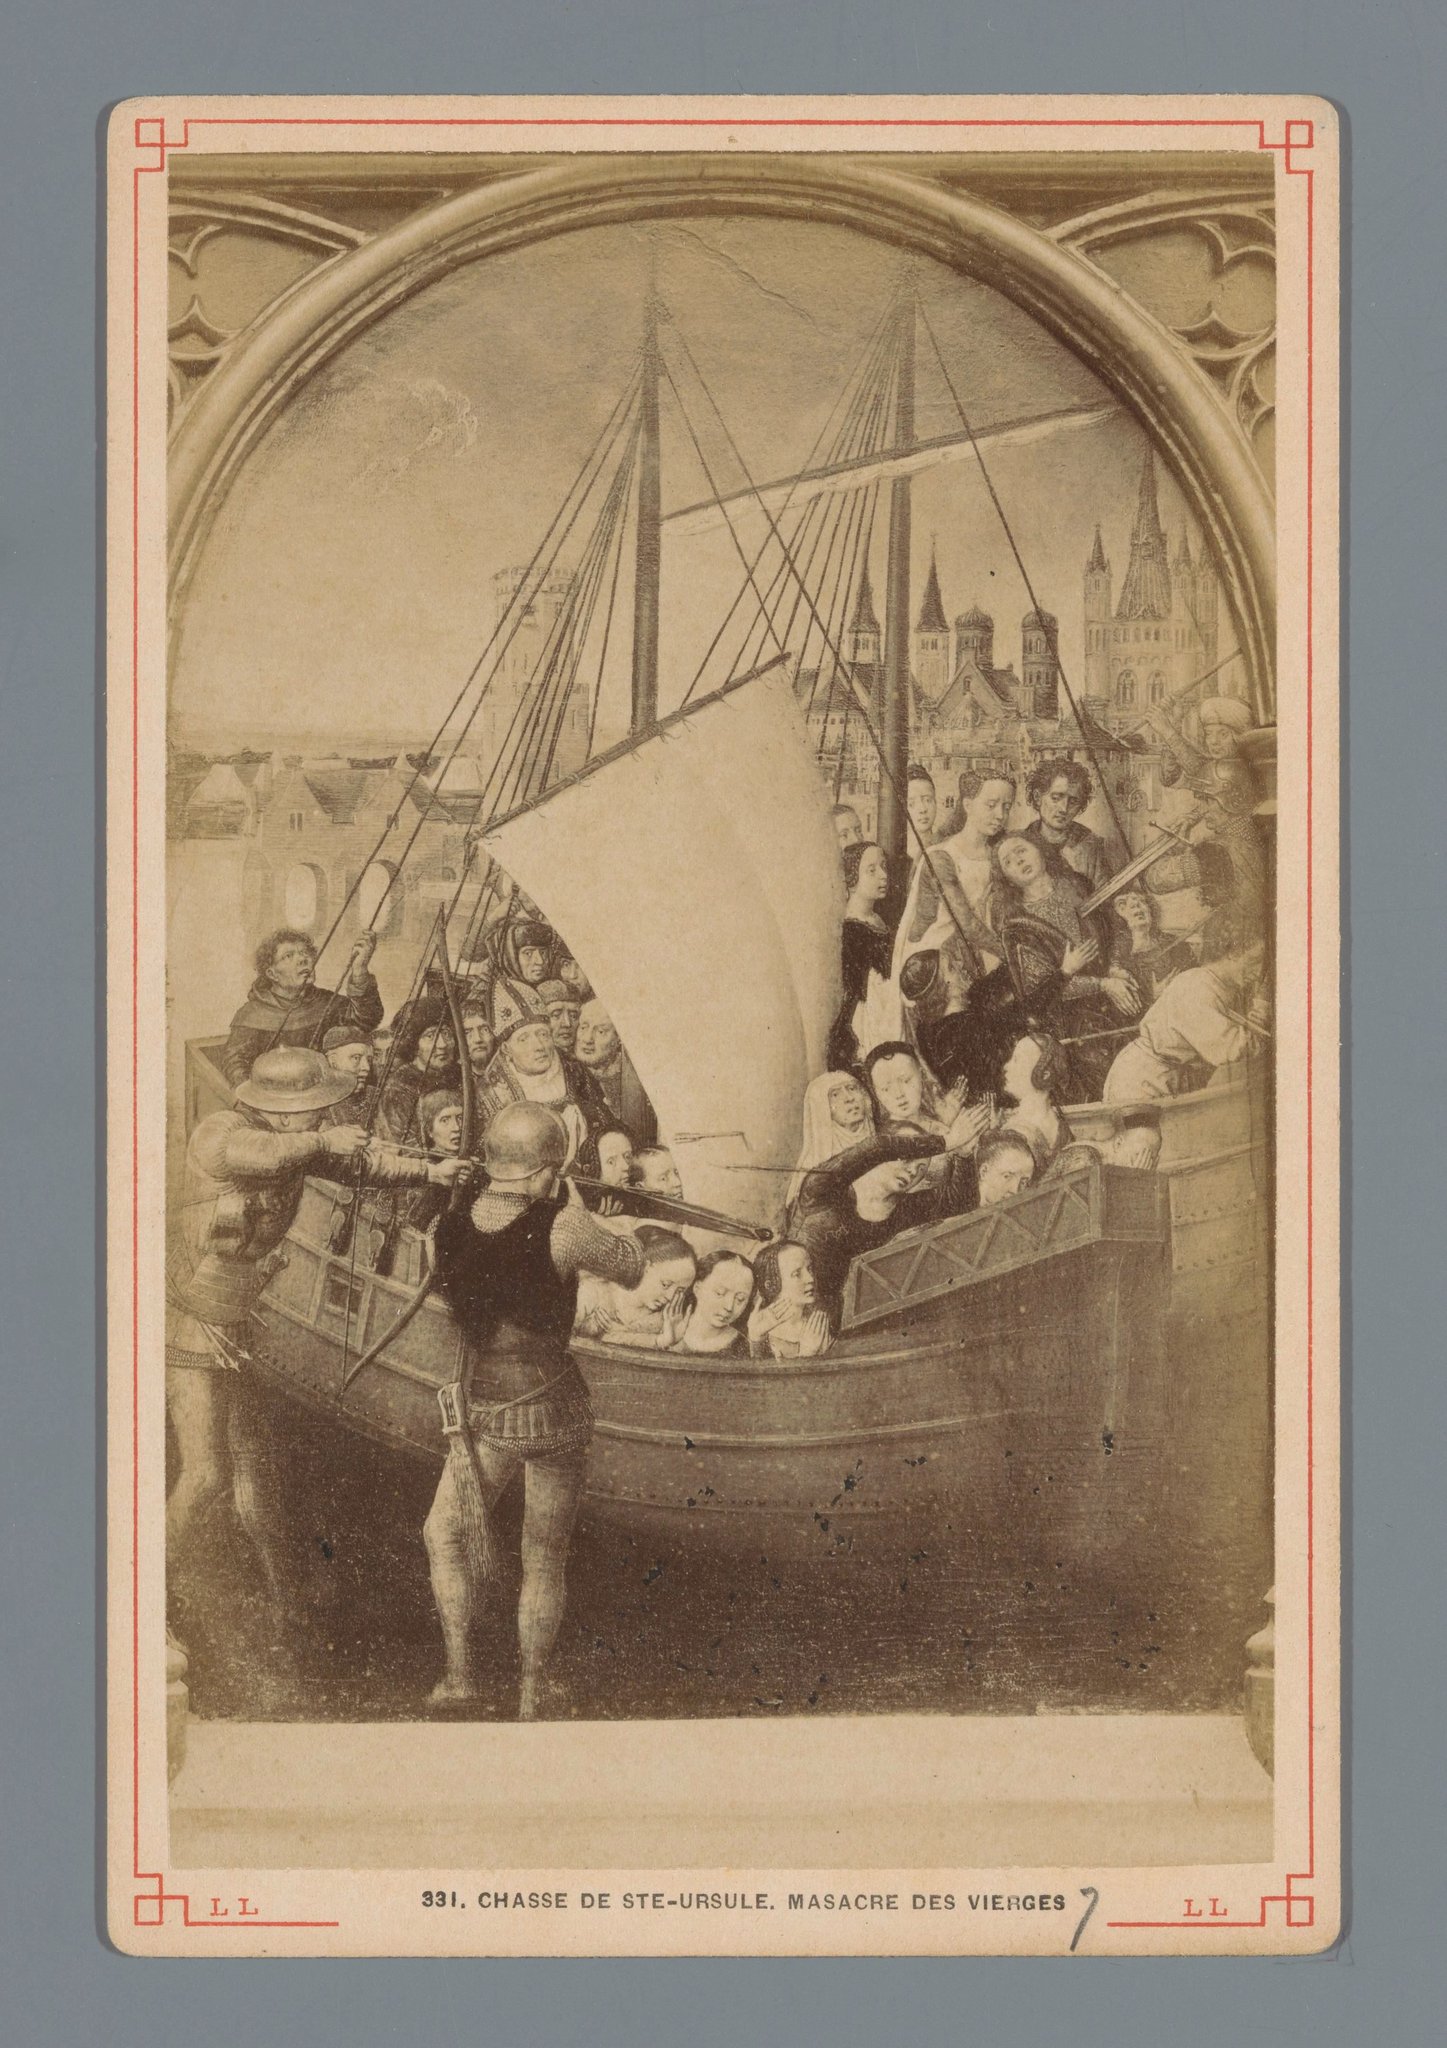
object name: cabinet photograph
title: Detail van de Ursula-schrijn van Hans Memling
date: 1864-1900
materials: cardboard, photographic support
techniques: albumen print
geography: sint-janshospitaal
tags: the pilgrimage of st. ursula and her companions to rome, massacre ~ war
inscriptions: number: ‘331.’, number: ‘7’